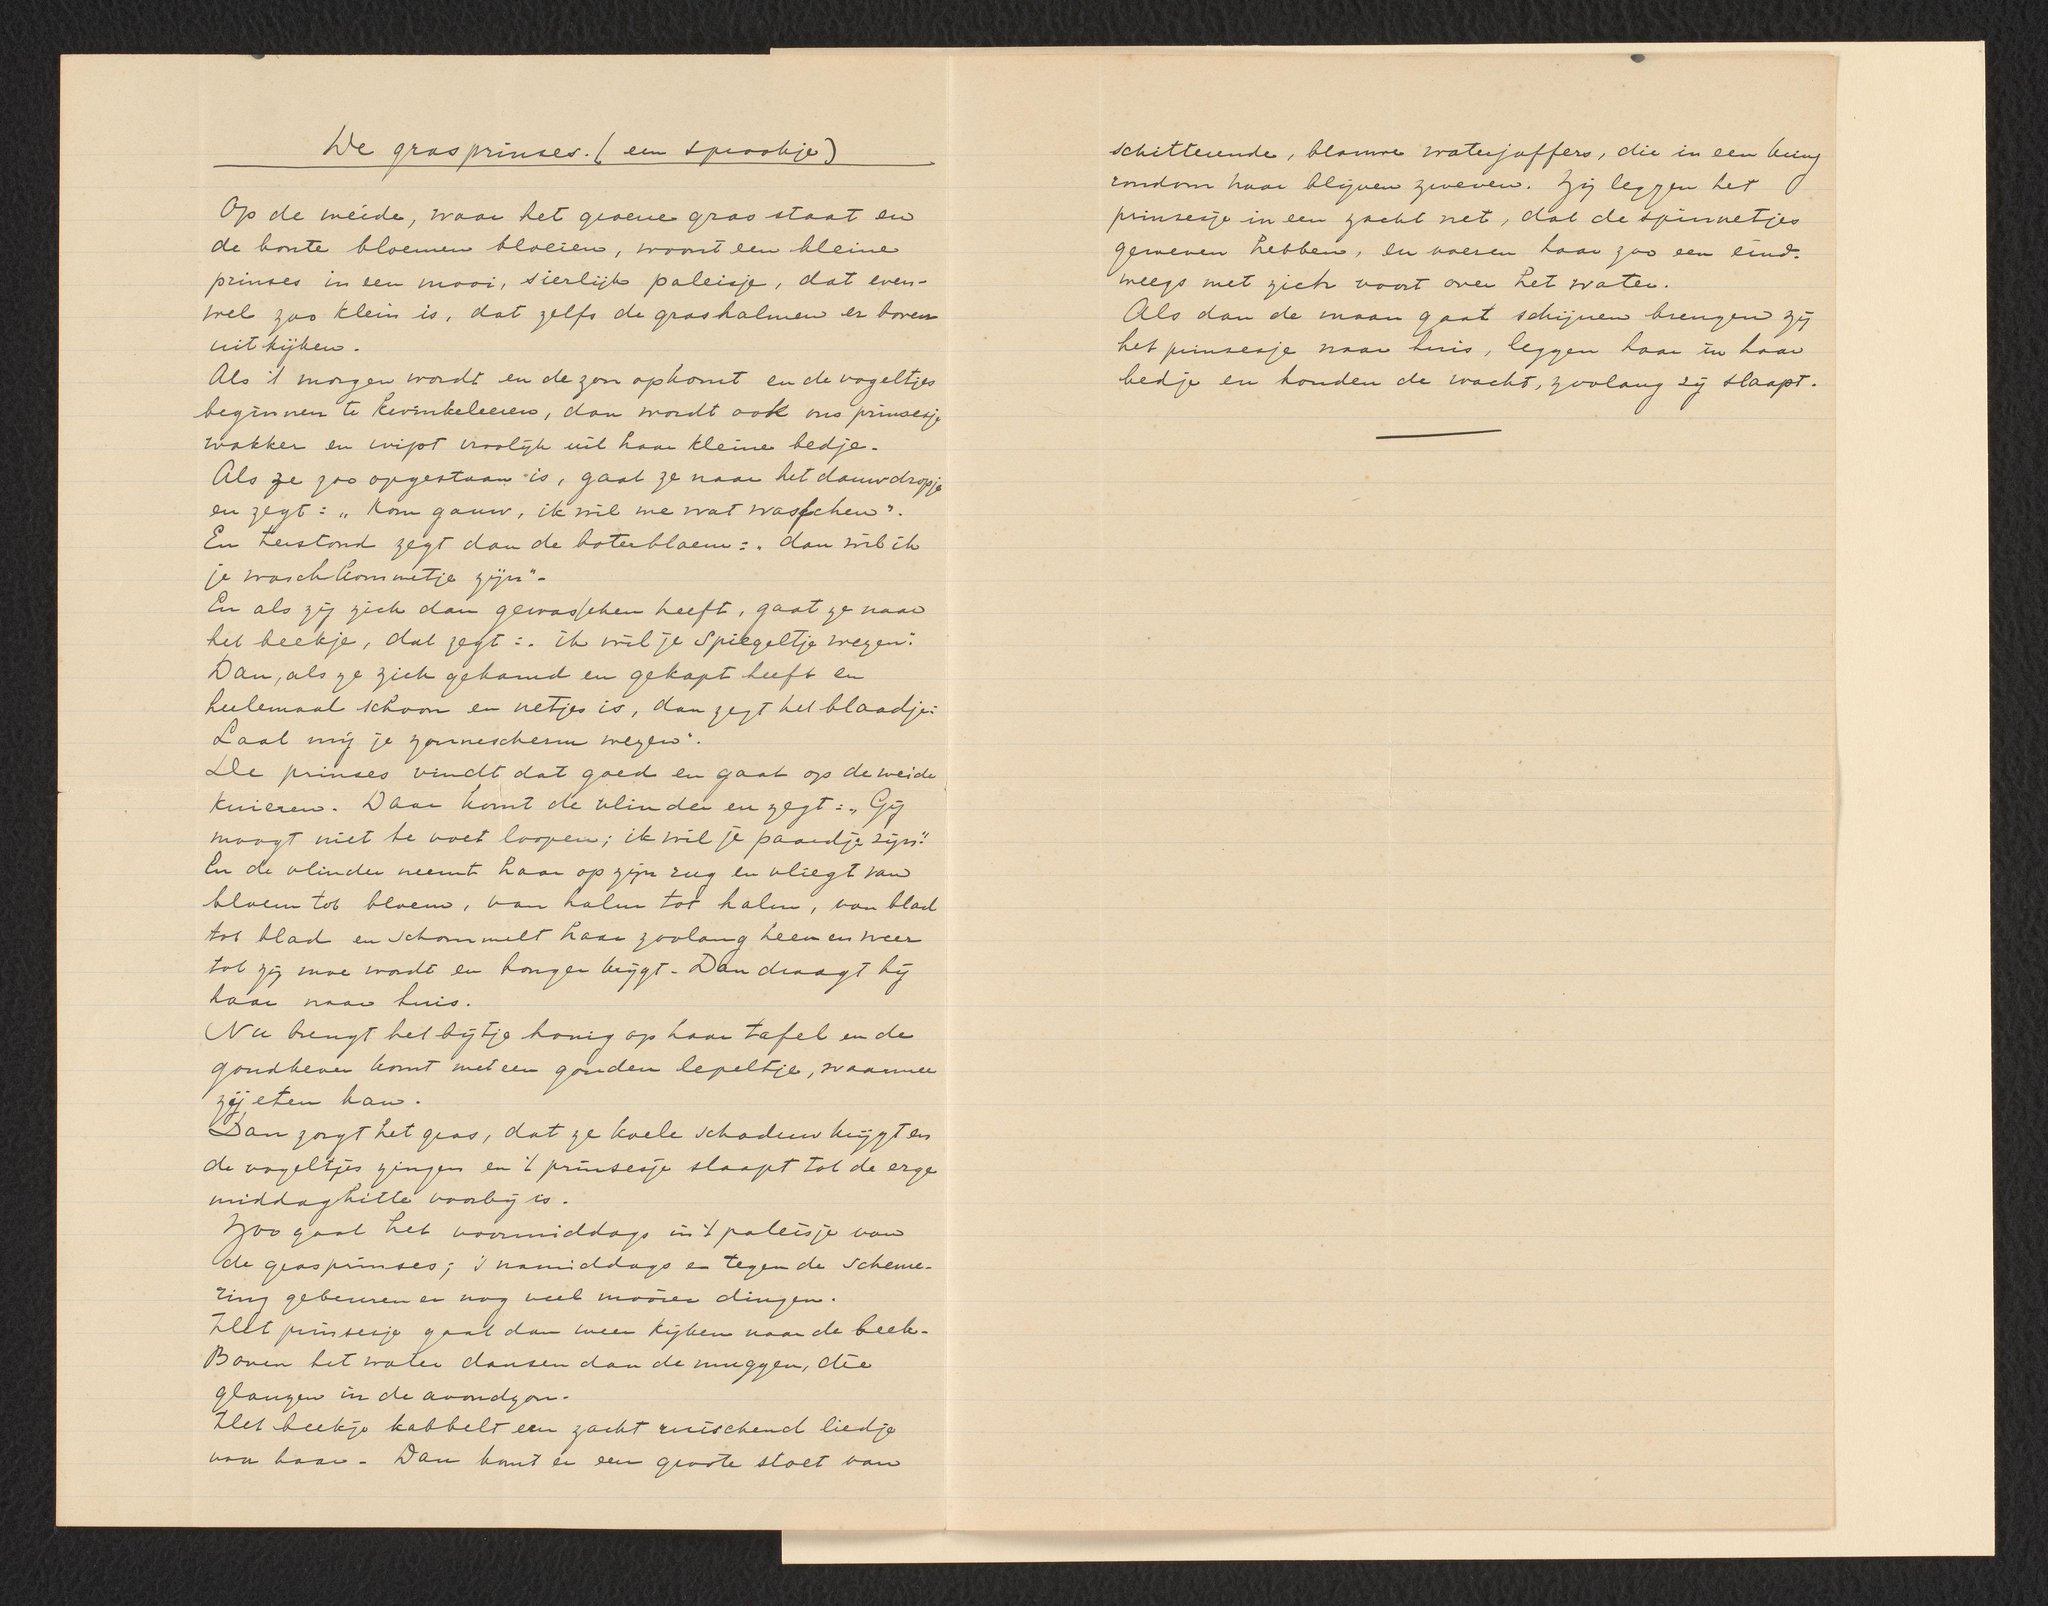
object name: document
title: De Grasprinses (een sprookje)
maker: edzard koning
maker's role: draughtsman, print maker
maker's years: 1869-1954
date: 1903-1931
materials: ink, paper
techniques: pen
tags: (koning, de grasprinses) specific works of literature (with author, title)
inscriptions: collector's mark: Lugt 2228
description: Ontwerp voor het niet uitgegeven sprookje: Koning, Edzard. De Grasprinses. Bussum: C.A.J. van Dishoeck, s.a.